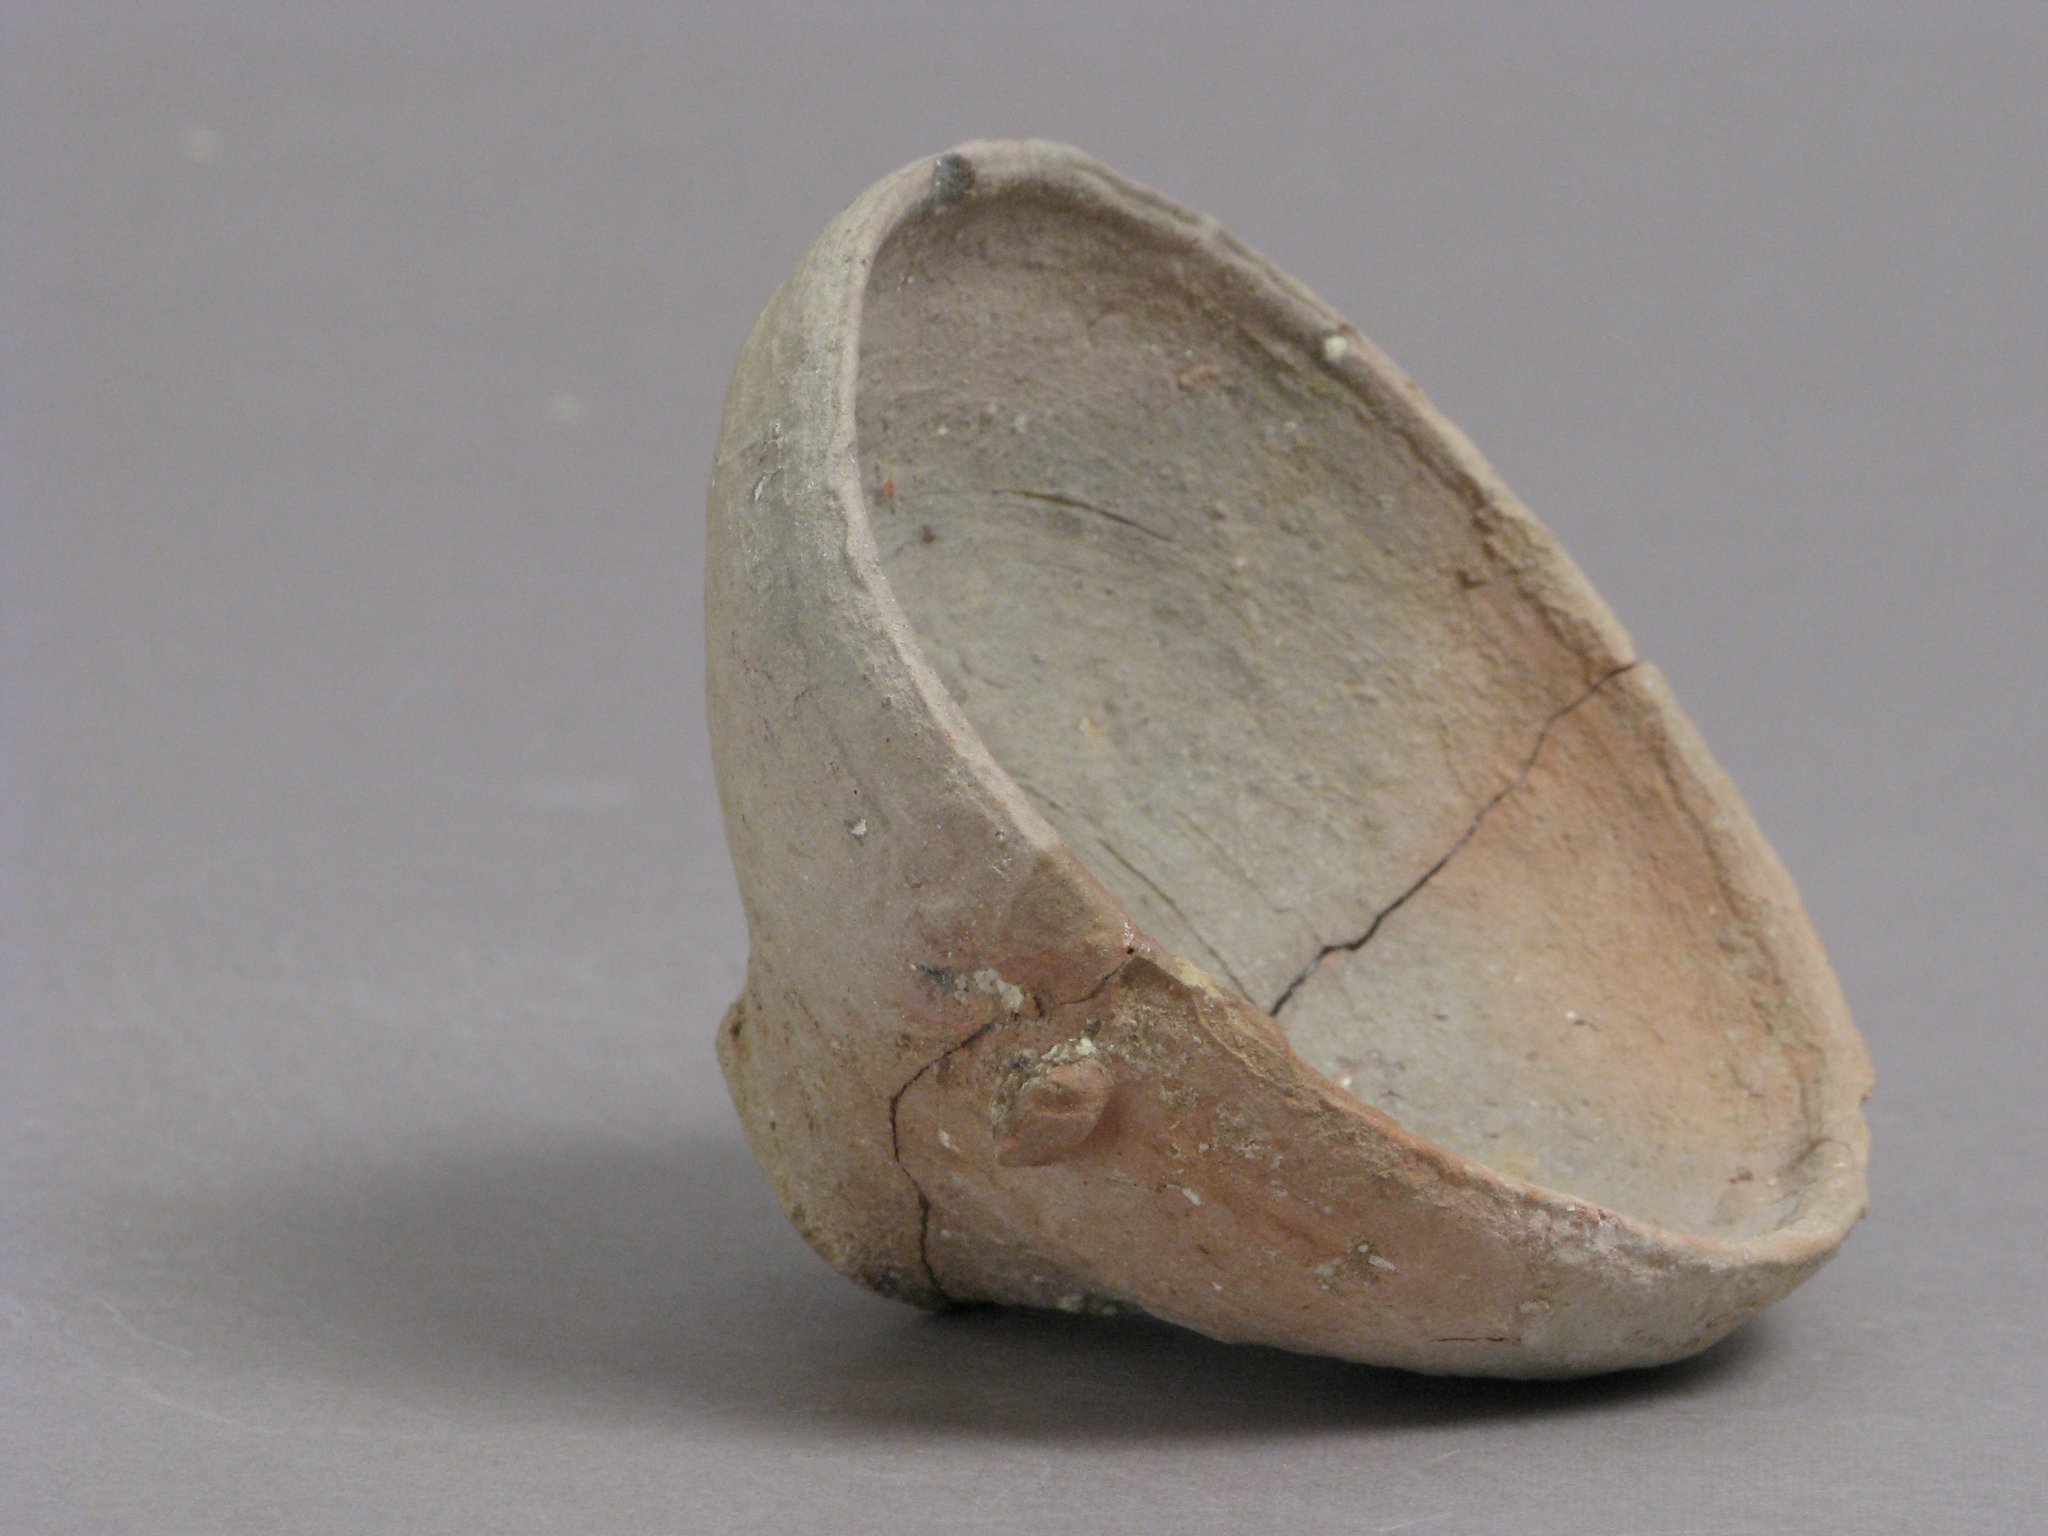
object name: cup or lid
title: Footless Cup or Lid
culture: coptic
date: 301-700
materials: earthenware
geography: egypt